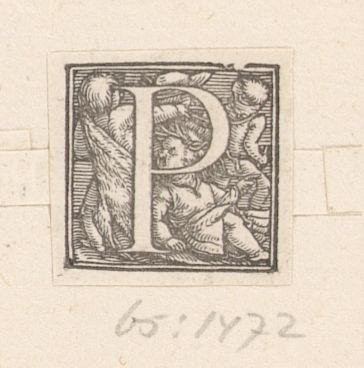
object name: print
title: Initiaal P met vier kinderen die paard en wagen spelen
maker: hans lützelburger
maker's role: print maker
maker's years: -1526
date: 1522-1526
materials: paper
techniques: woodcut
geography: basel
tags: initial, cupids: 'amores', 'amoretti', 'putti'